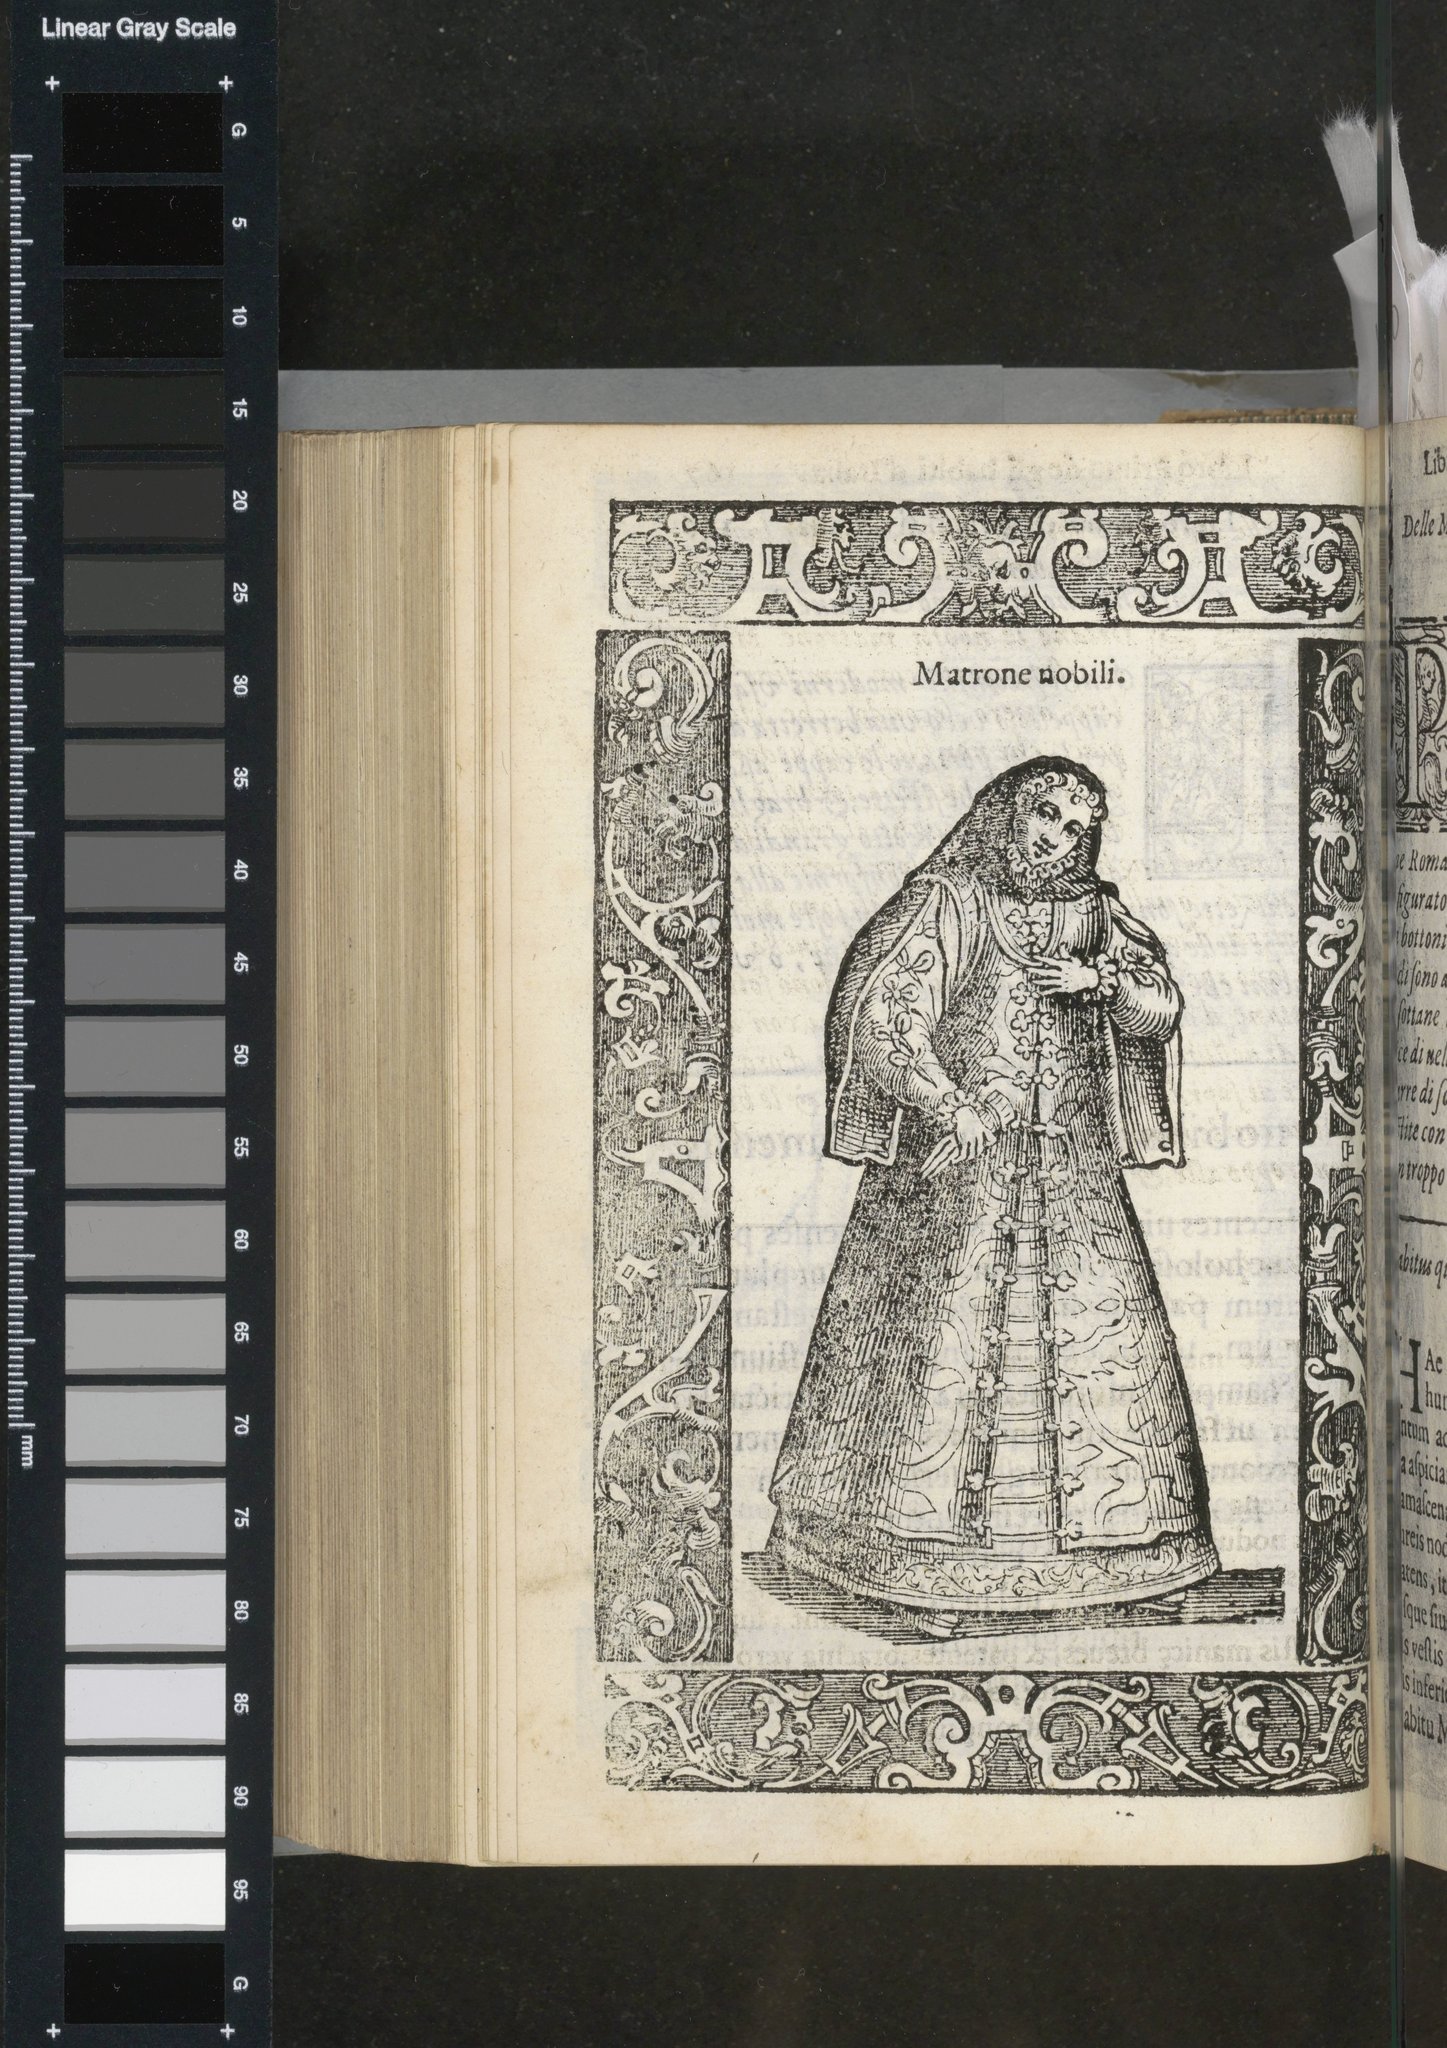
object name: costume print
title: Habiti antichi, et moderni di tutto il mondo...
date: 1598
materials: paper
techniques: woodcut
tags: fashion plates